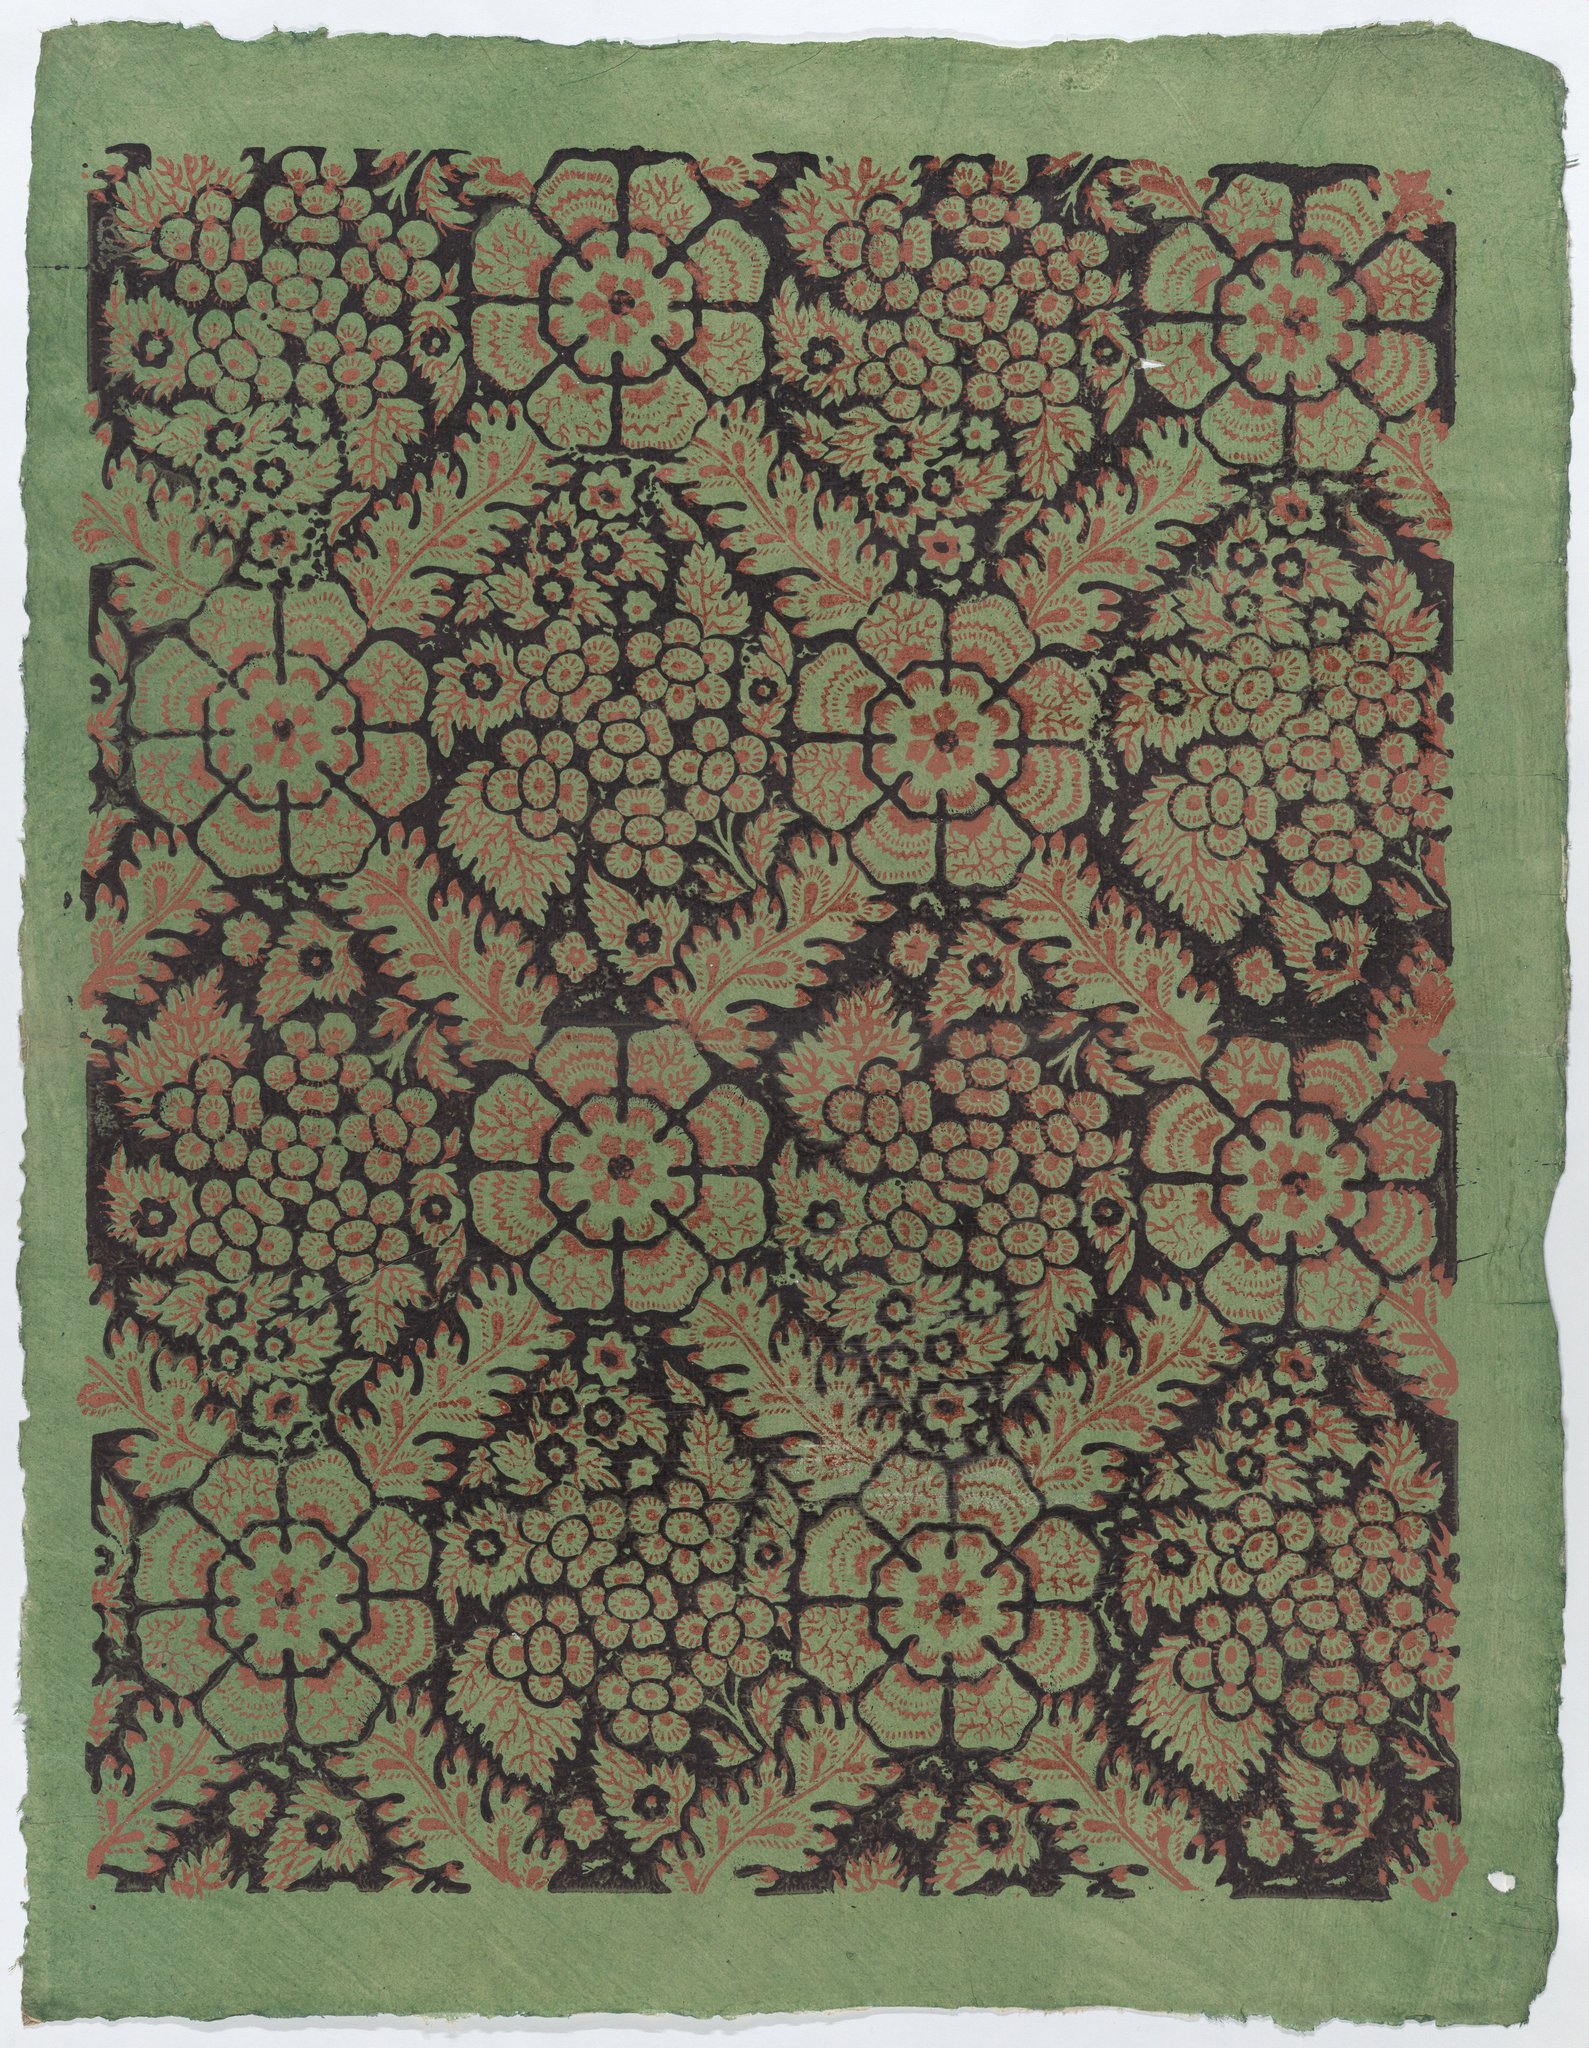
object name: print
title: Sheet with overall floral pattern on green background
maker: Anonymous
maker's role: artist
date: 1767-1866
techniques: relief print